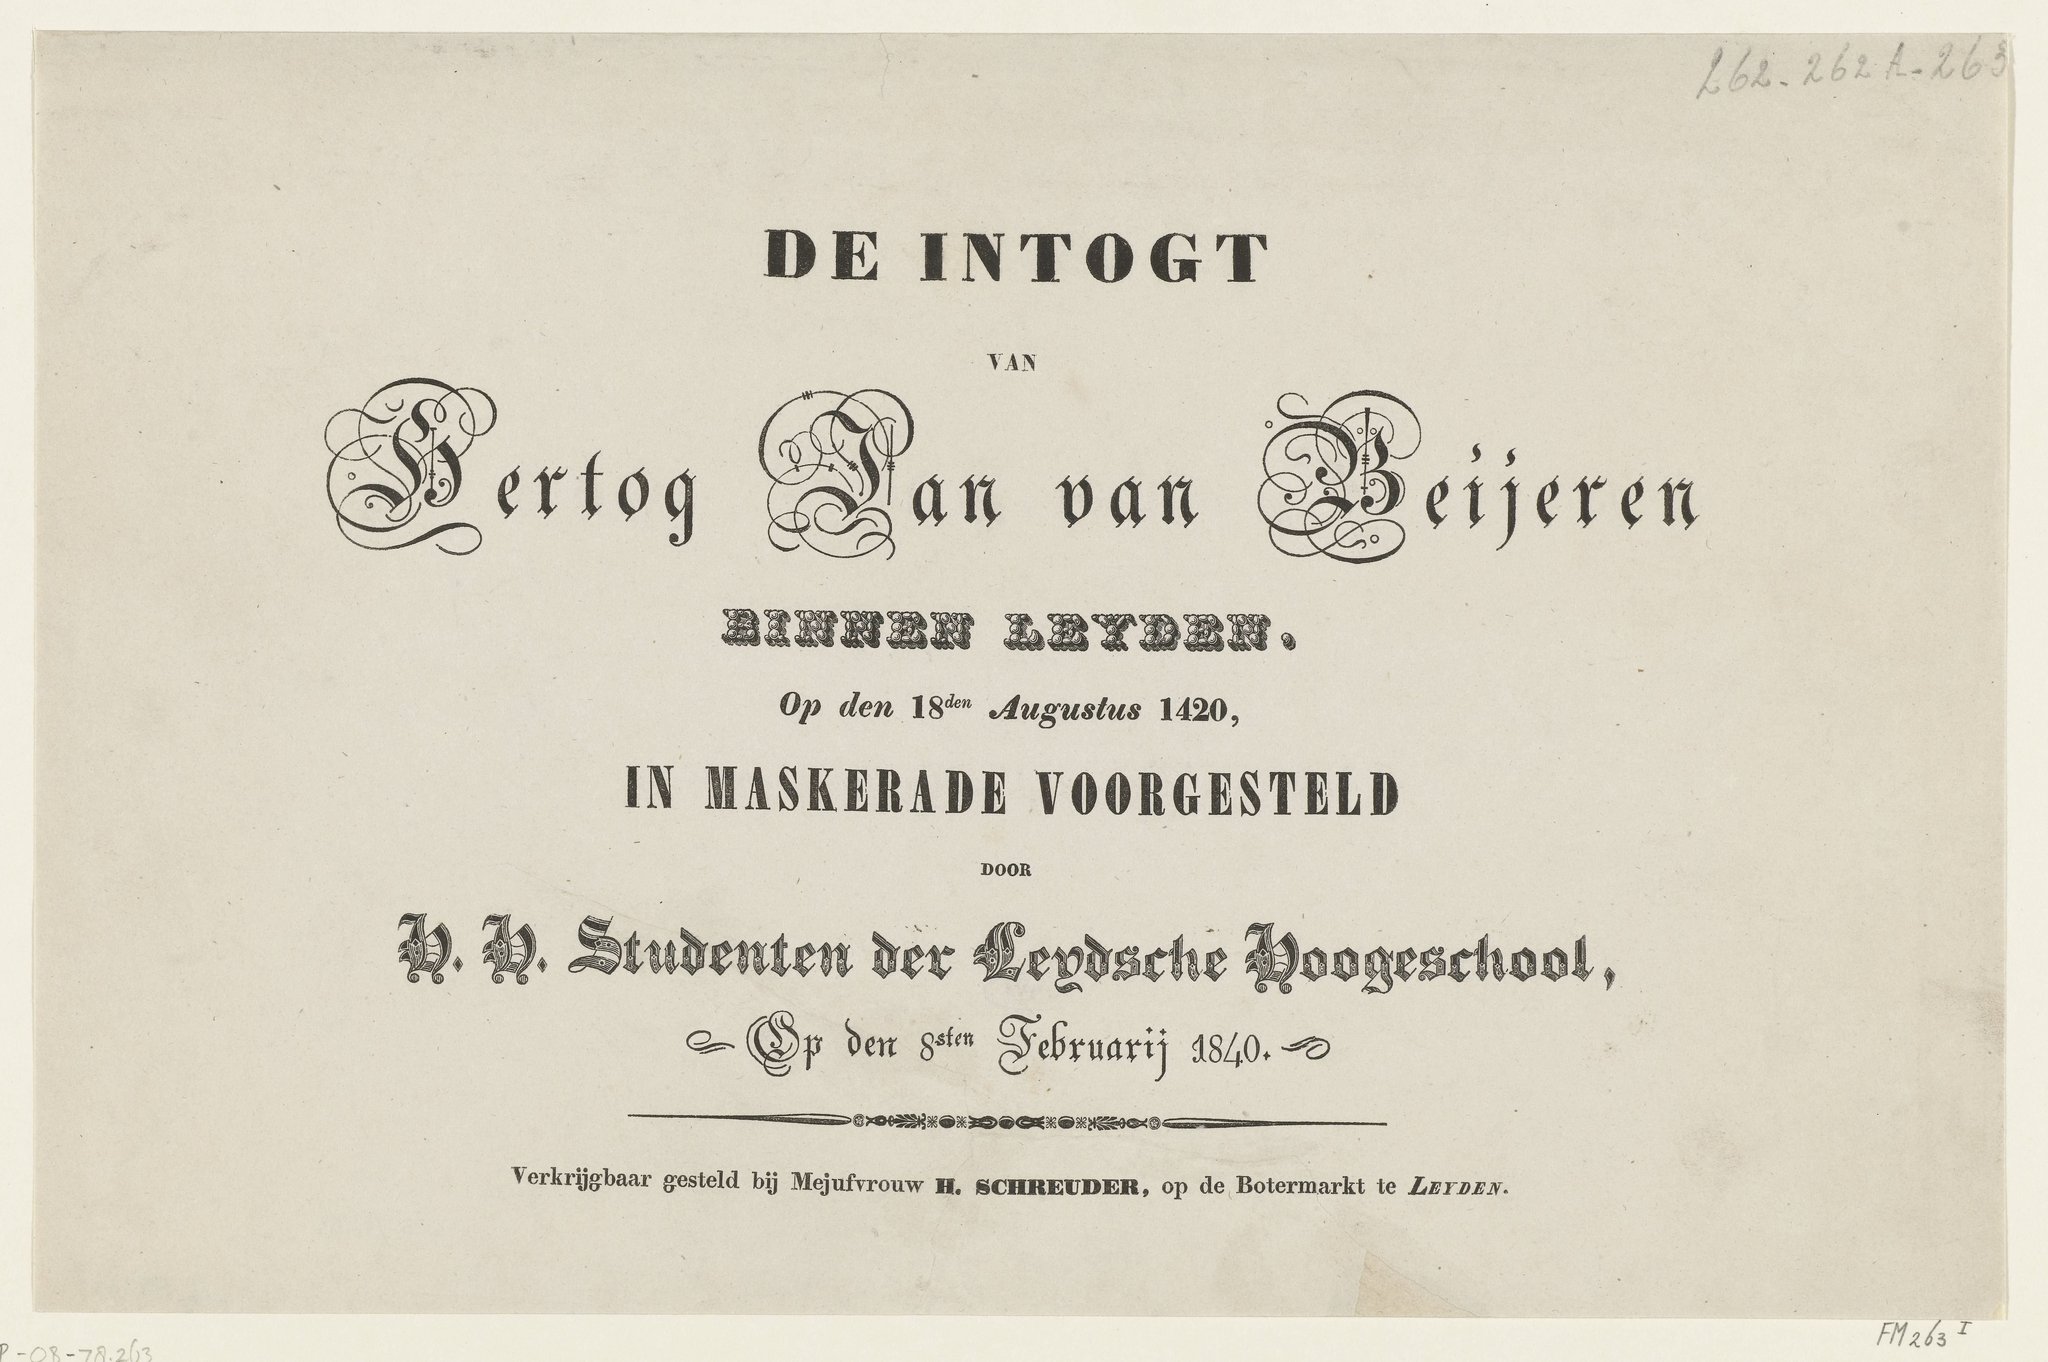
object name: print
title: Maskerade van de intocht van hertog Jan van Beieren te Leiden op 18 augustus 1420 door de Leidse studenten op 8 februari 1840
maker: mejuffrouw h. schreuder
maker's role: publisher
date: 1840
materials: paper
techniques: letterpress printing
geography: leiden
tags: jan van beieren, leiden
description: Titelblad voor de prentserie van de Maskerade van de intocht van hertog Jan van Beieren te Leiden op 18 augustus 1420 door de Leidse studenten op 8 februari 1840.